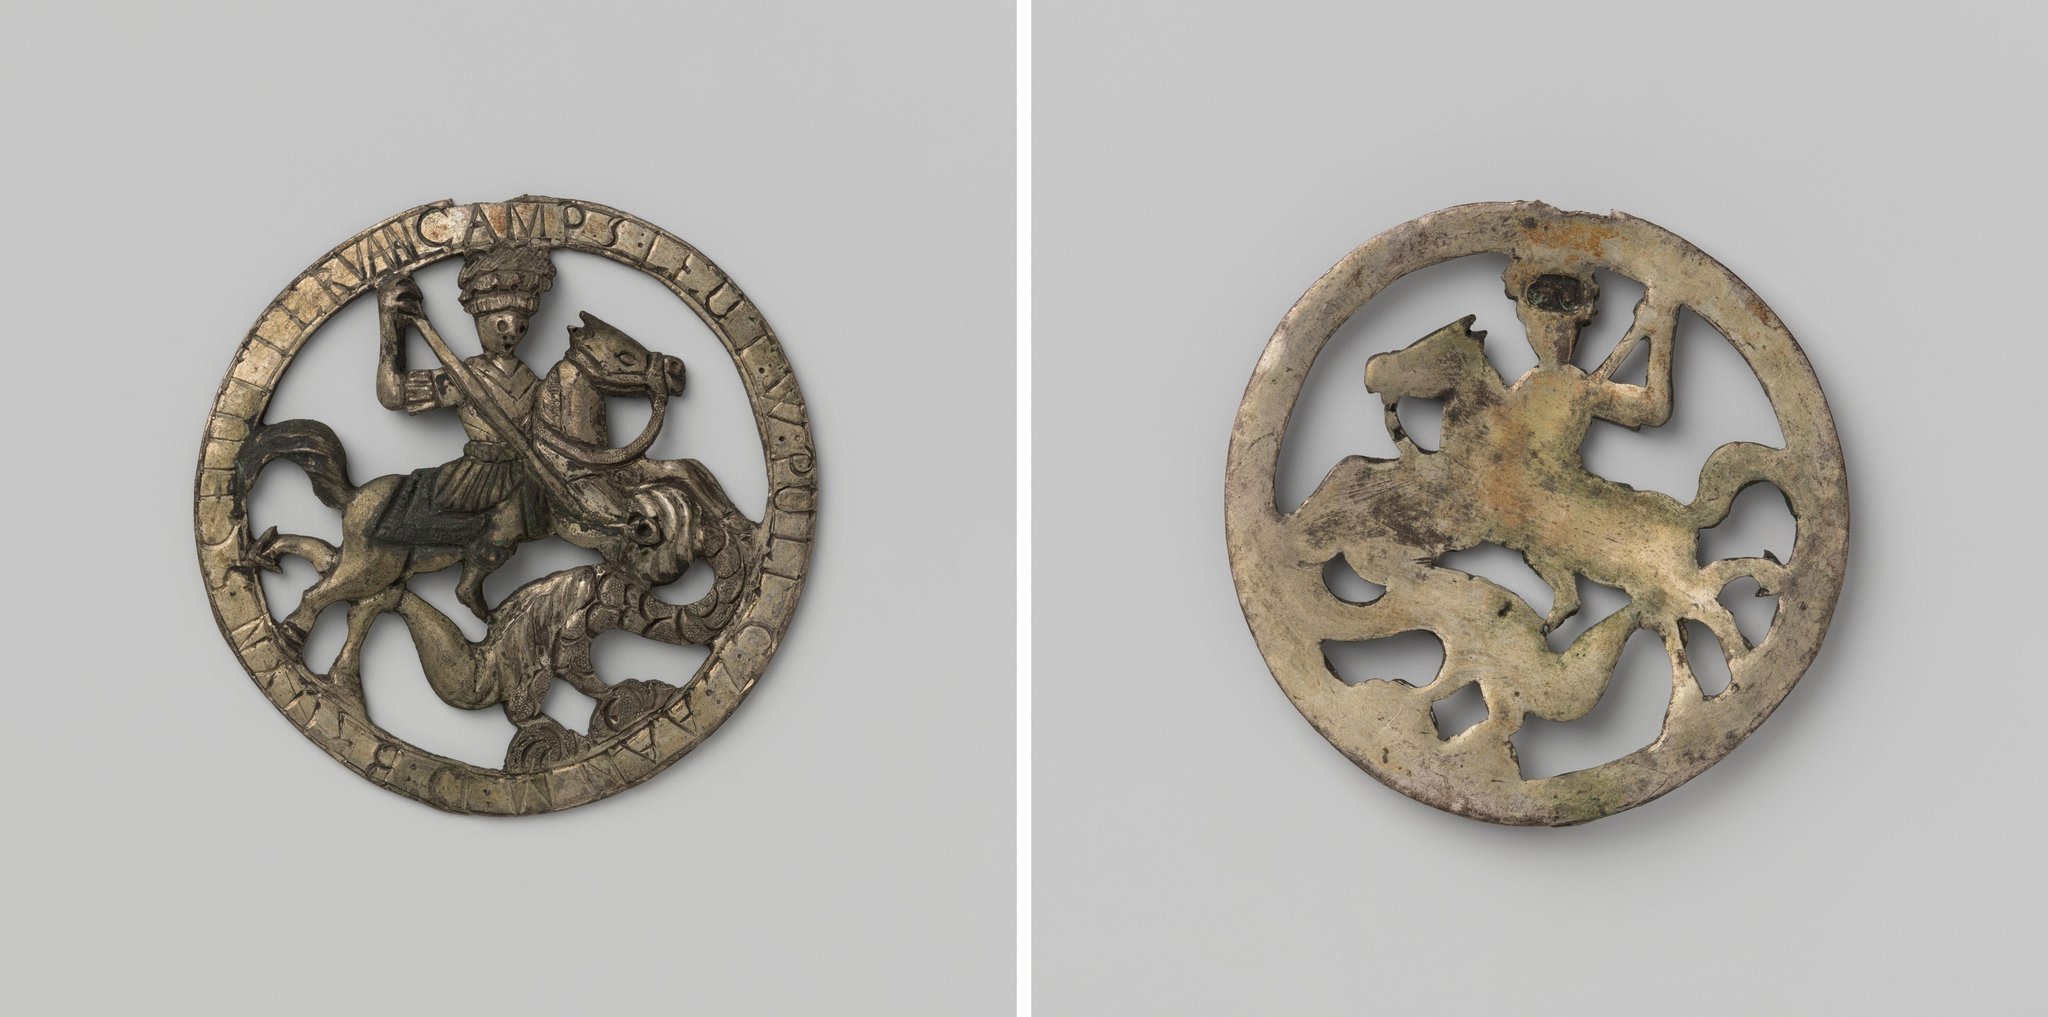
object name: marksman medal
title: Schutterij van Kampen, schutterspenning door luitenant W. Pull C.z. vereerd aan schutter M.D. Bruyn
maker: Anonymous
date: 1600-1750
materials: silver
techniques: casting, embroidery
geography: kampen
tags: w. pull c.z., m.d. bruyn, kampen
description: Eenzijdige zilveren opengewerkte penning. Voorzijde: St. Joris te paard met speer in rechterhand bestrijdt ter aarde liggende draak binnen omschrift. Keerzijde: blanco.